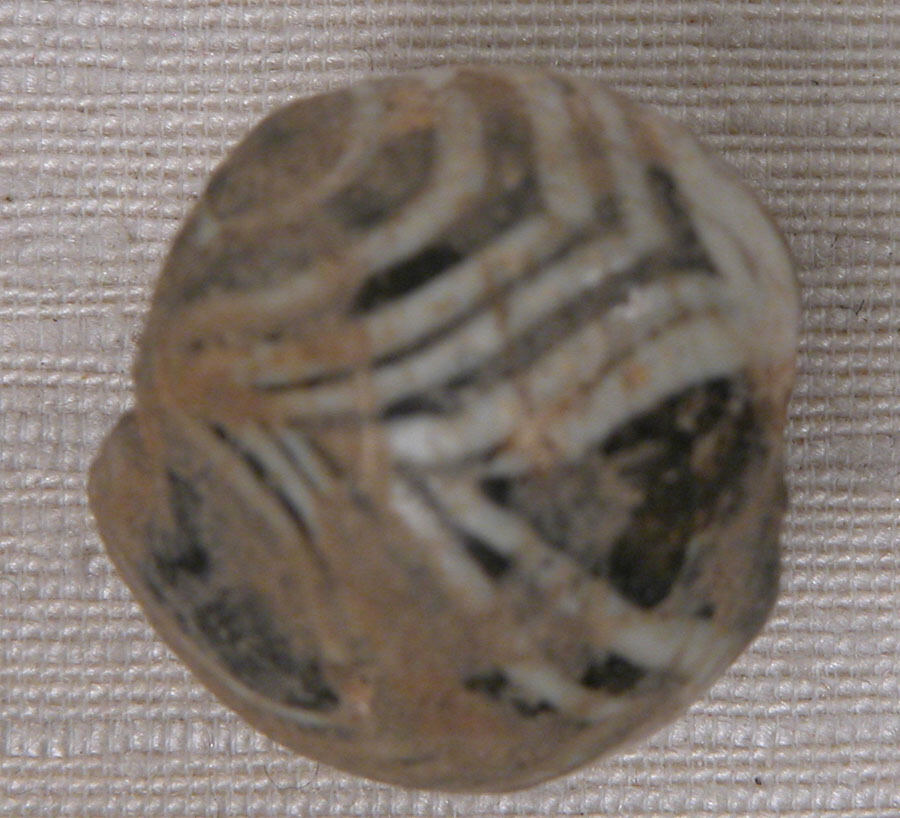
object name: bead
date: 701-1300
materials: glass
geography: iran